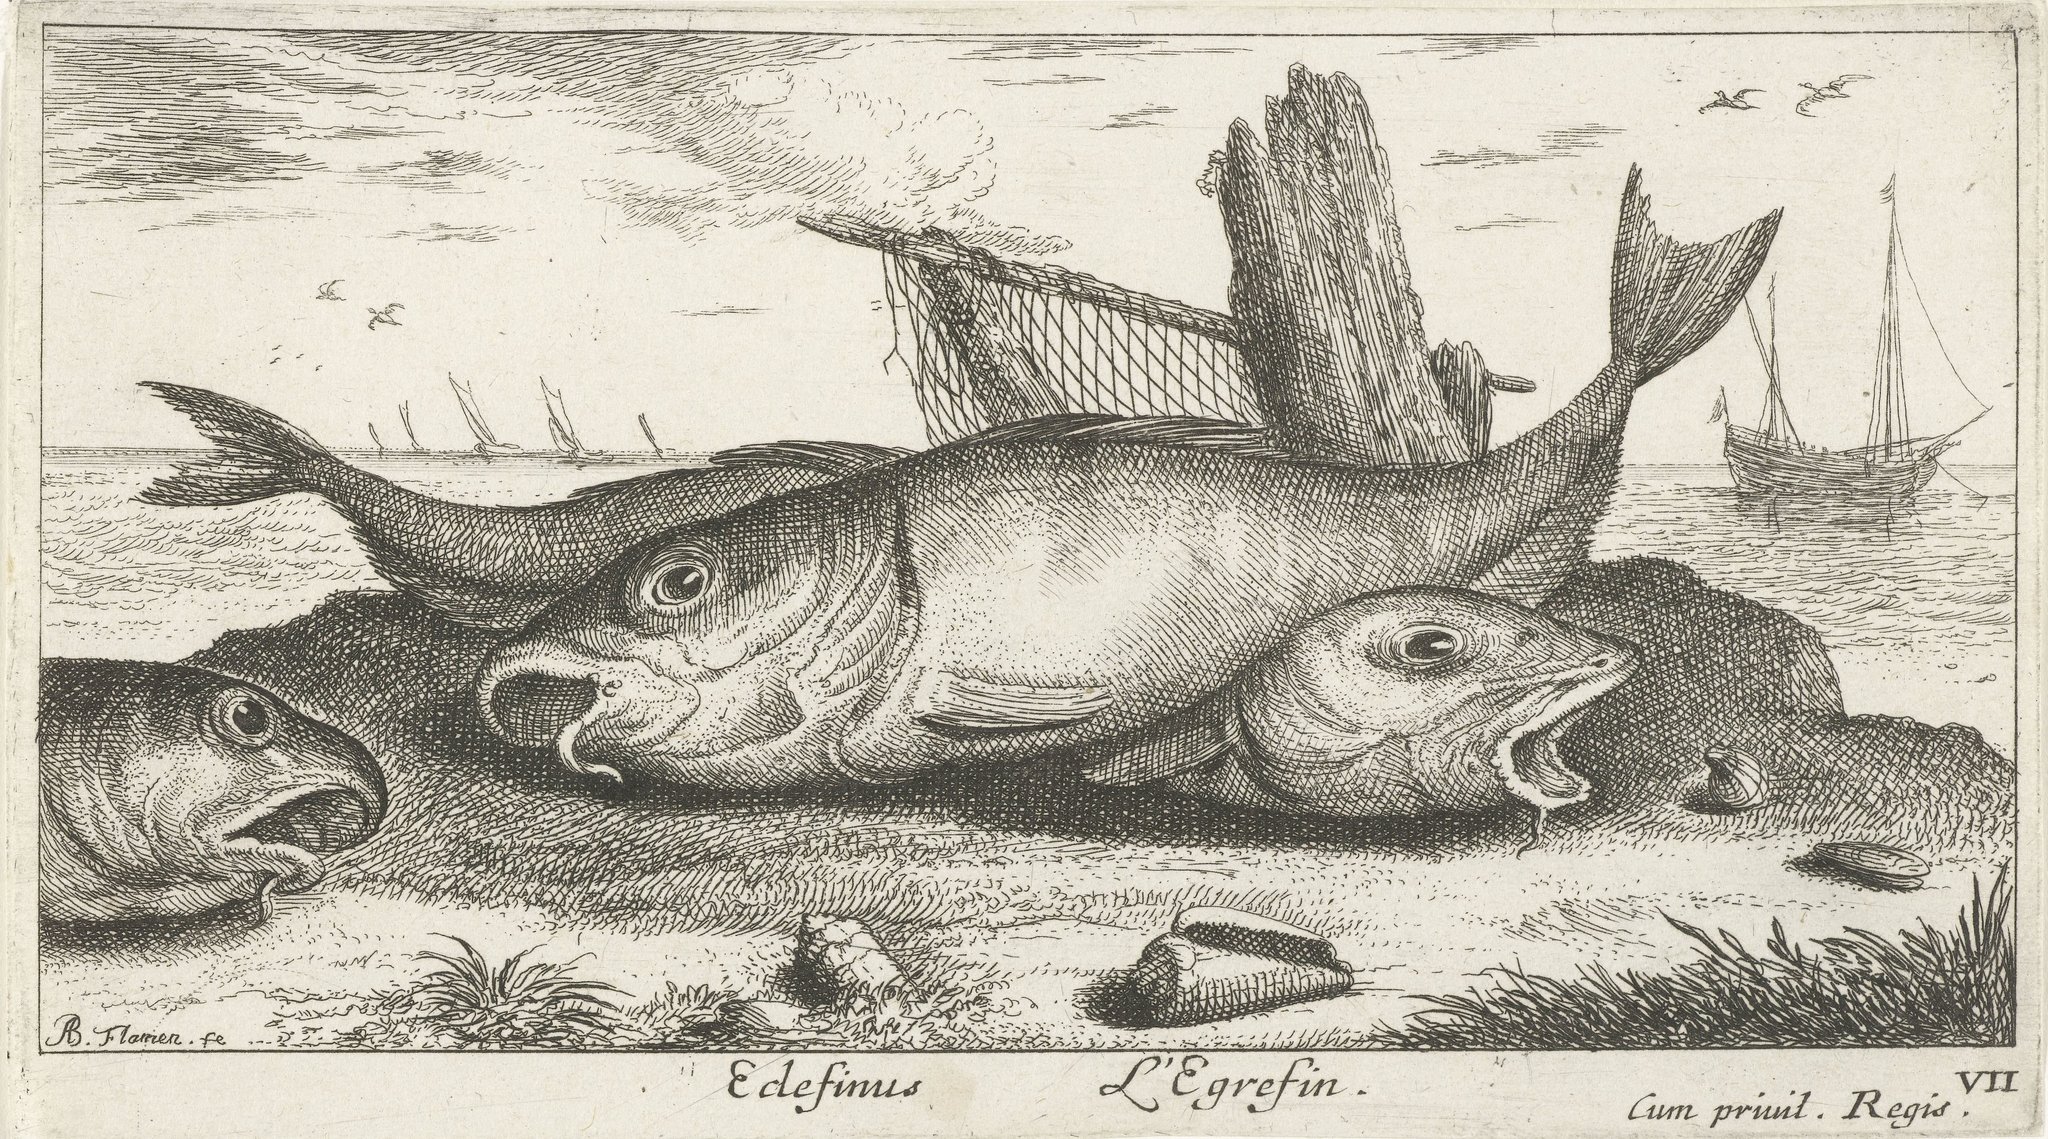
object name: print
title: Vissen en andere zeedieren - zoutwater derde reeks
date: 1664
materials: paper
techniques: etching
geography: paris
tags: fishes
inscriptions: collector's mark: Lugt 2228